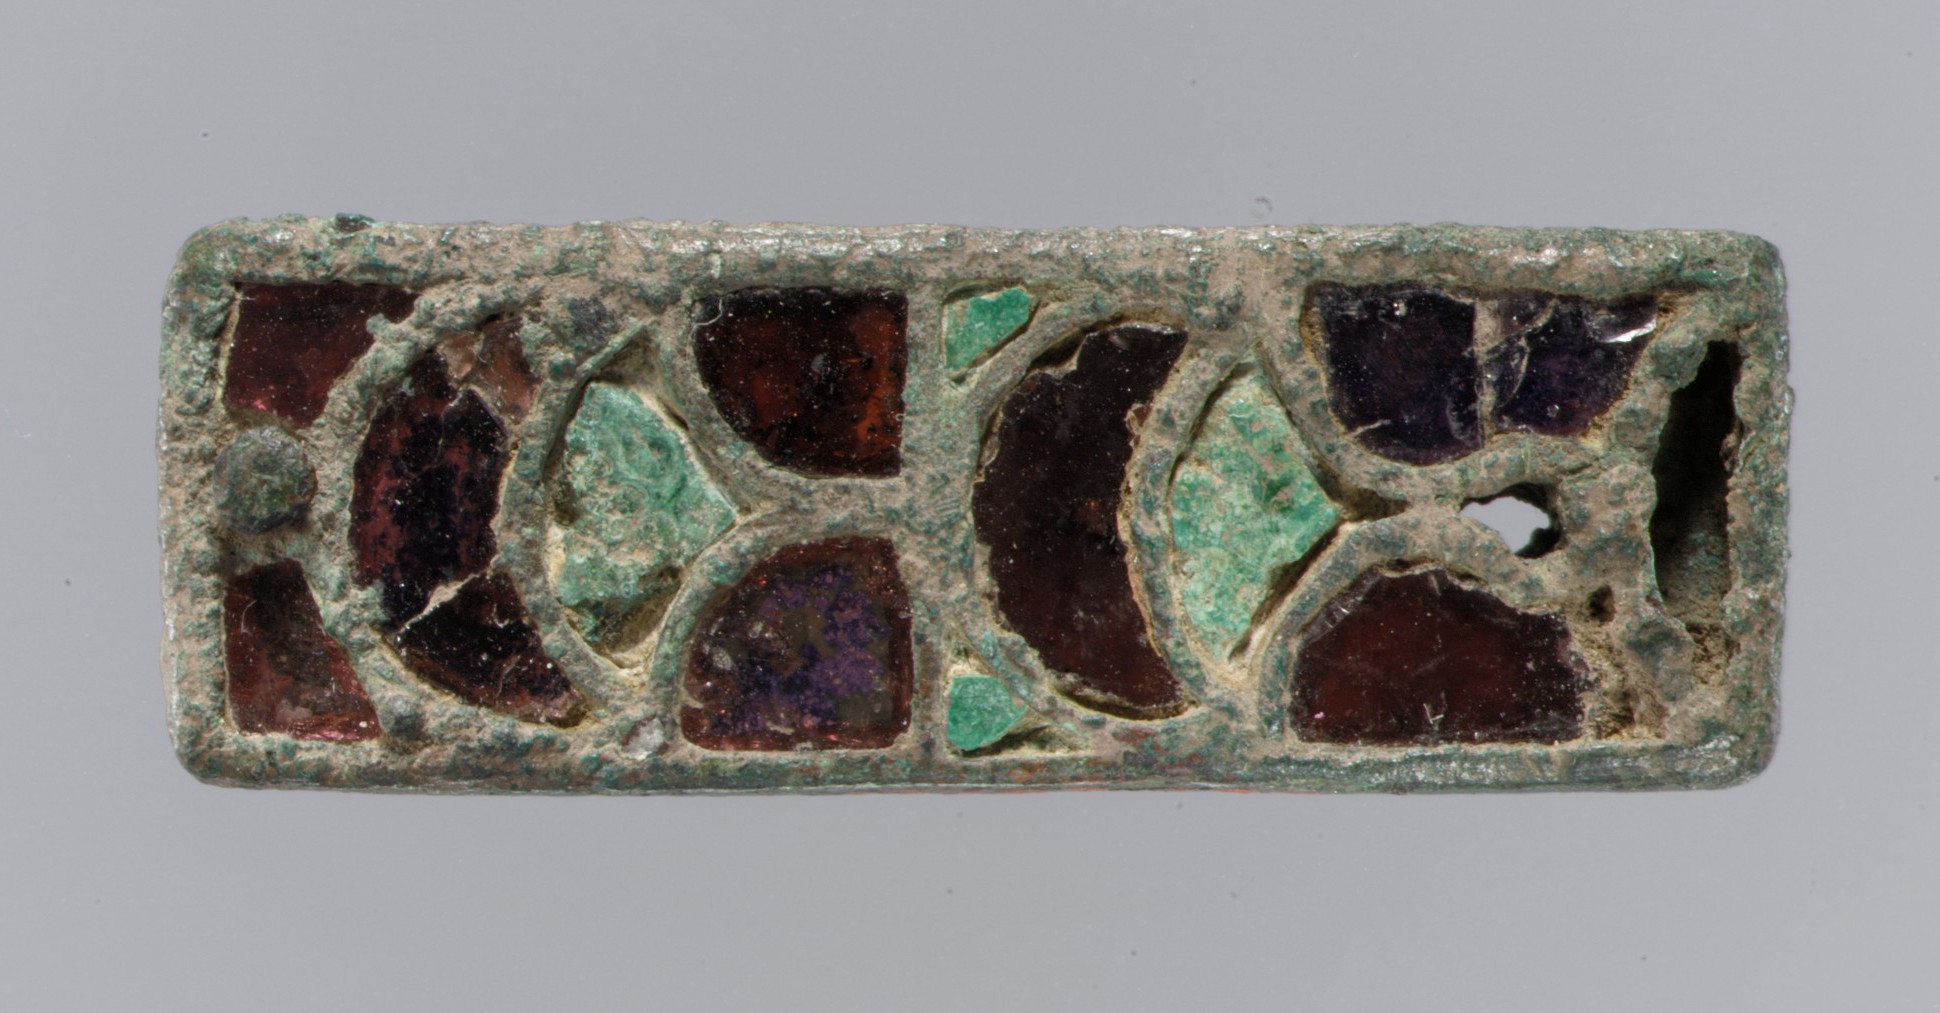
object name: plaque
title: Rectangular Mount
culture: visigothic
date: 551-600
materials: copper alloy, garnet